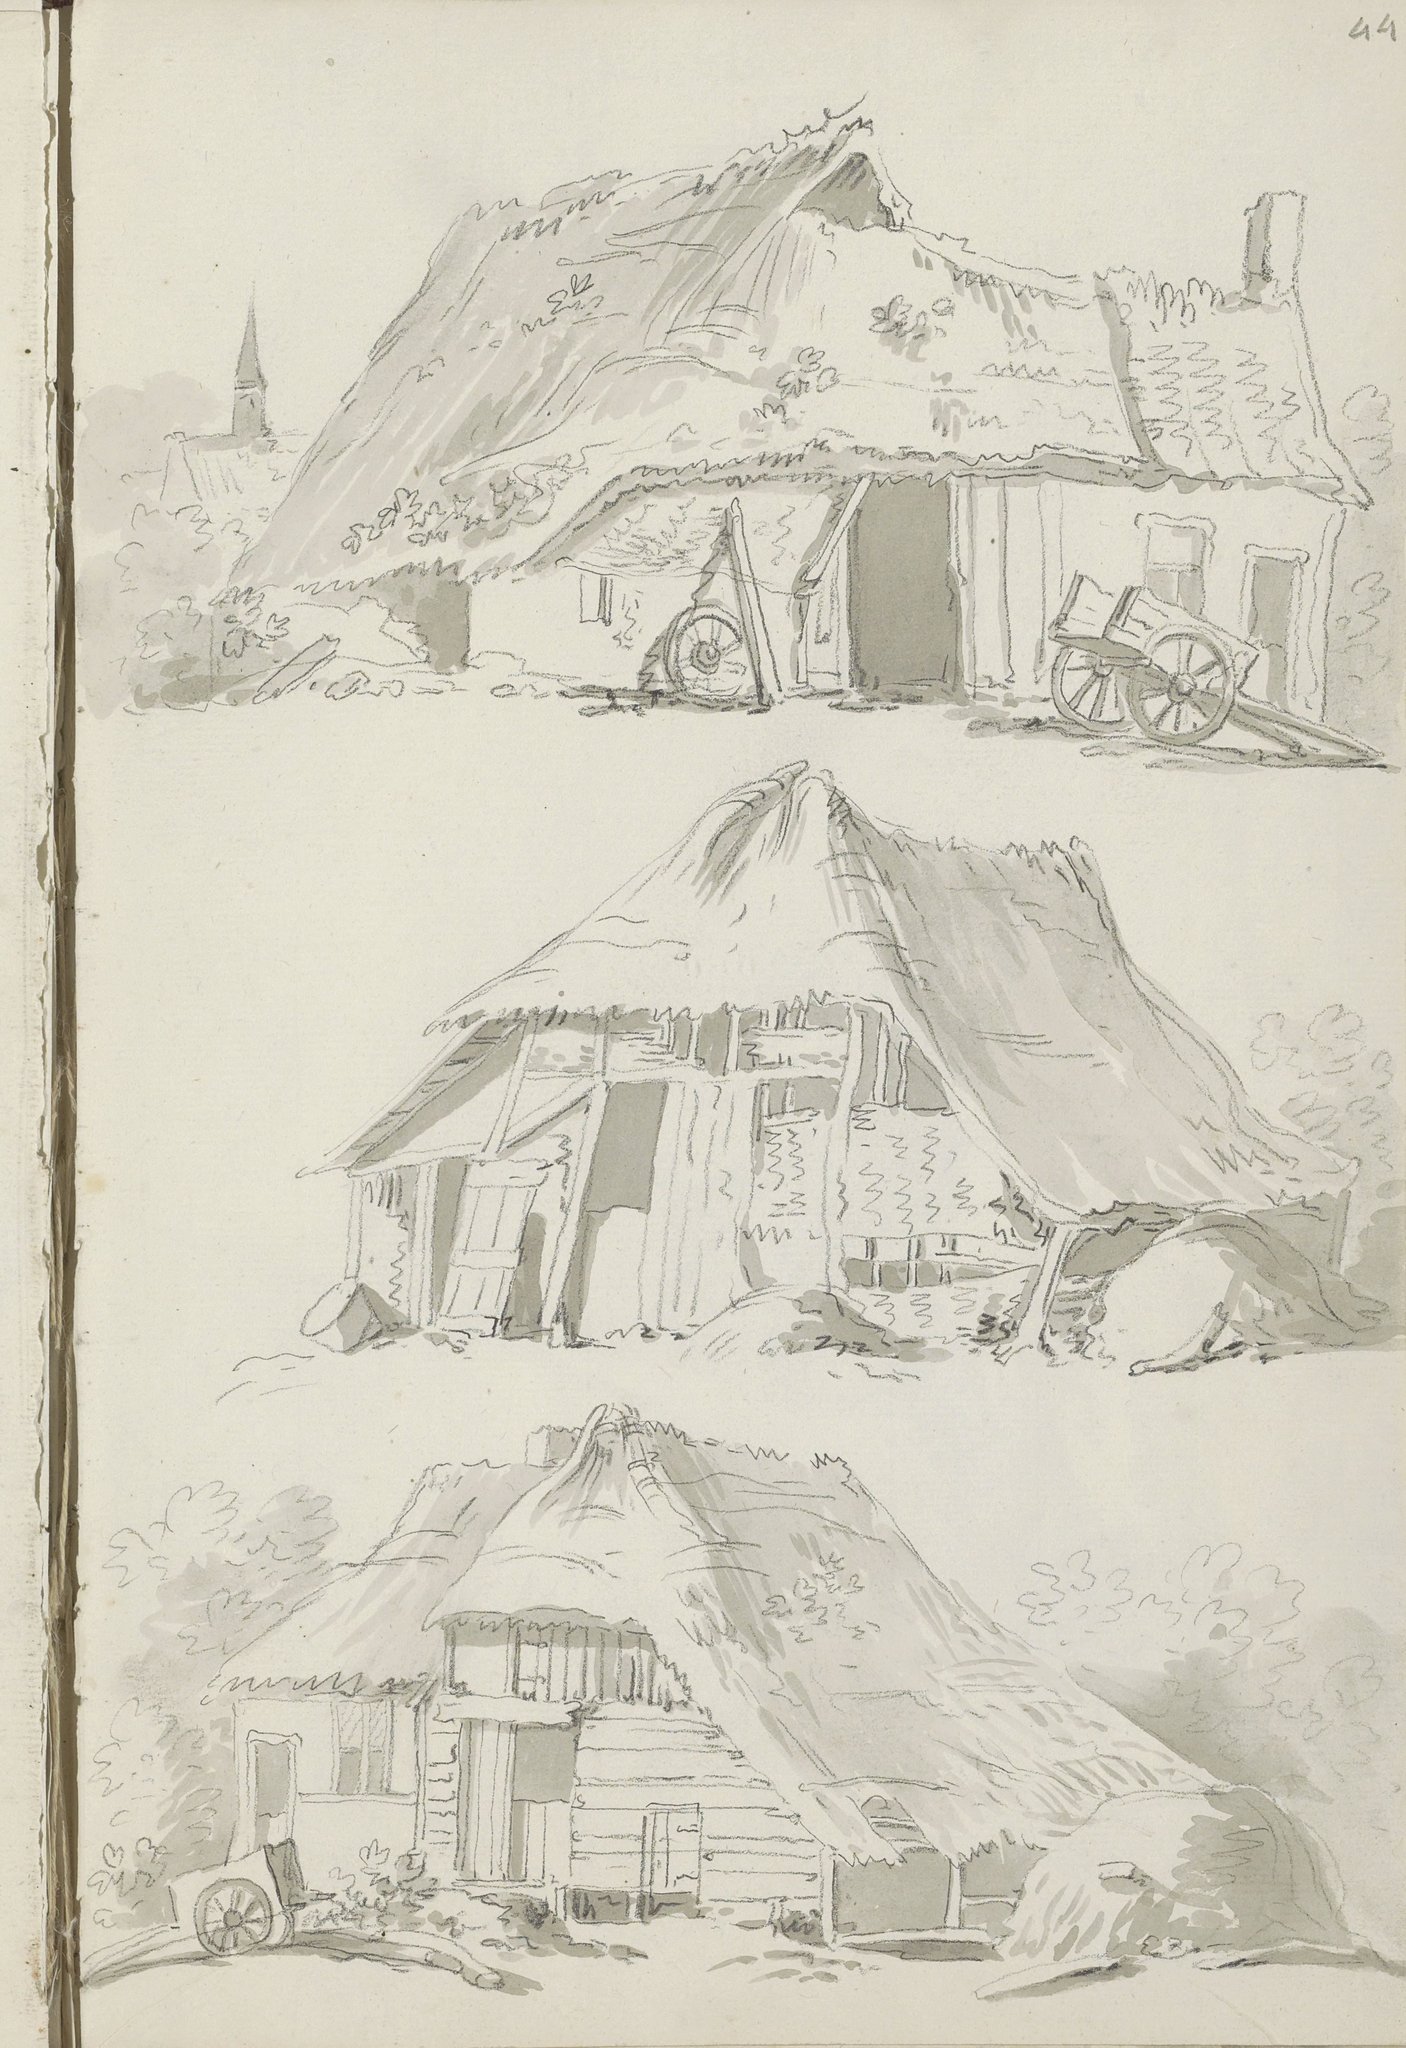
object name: sketchbook leaf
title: Boerderijen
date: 1780-1800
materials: paper, pencil, watercolor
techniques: brush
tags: farm (building)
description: Blad 13 recto uit een schetsboek met 16 bladen.